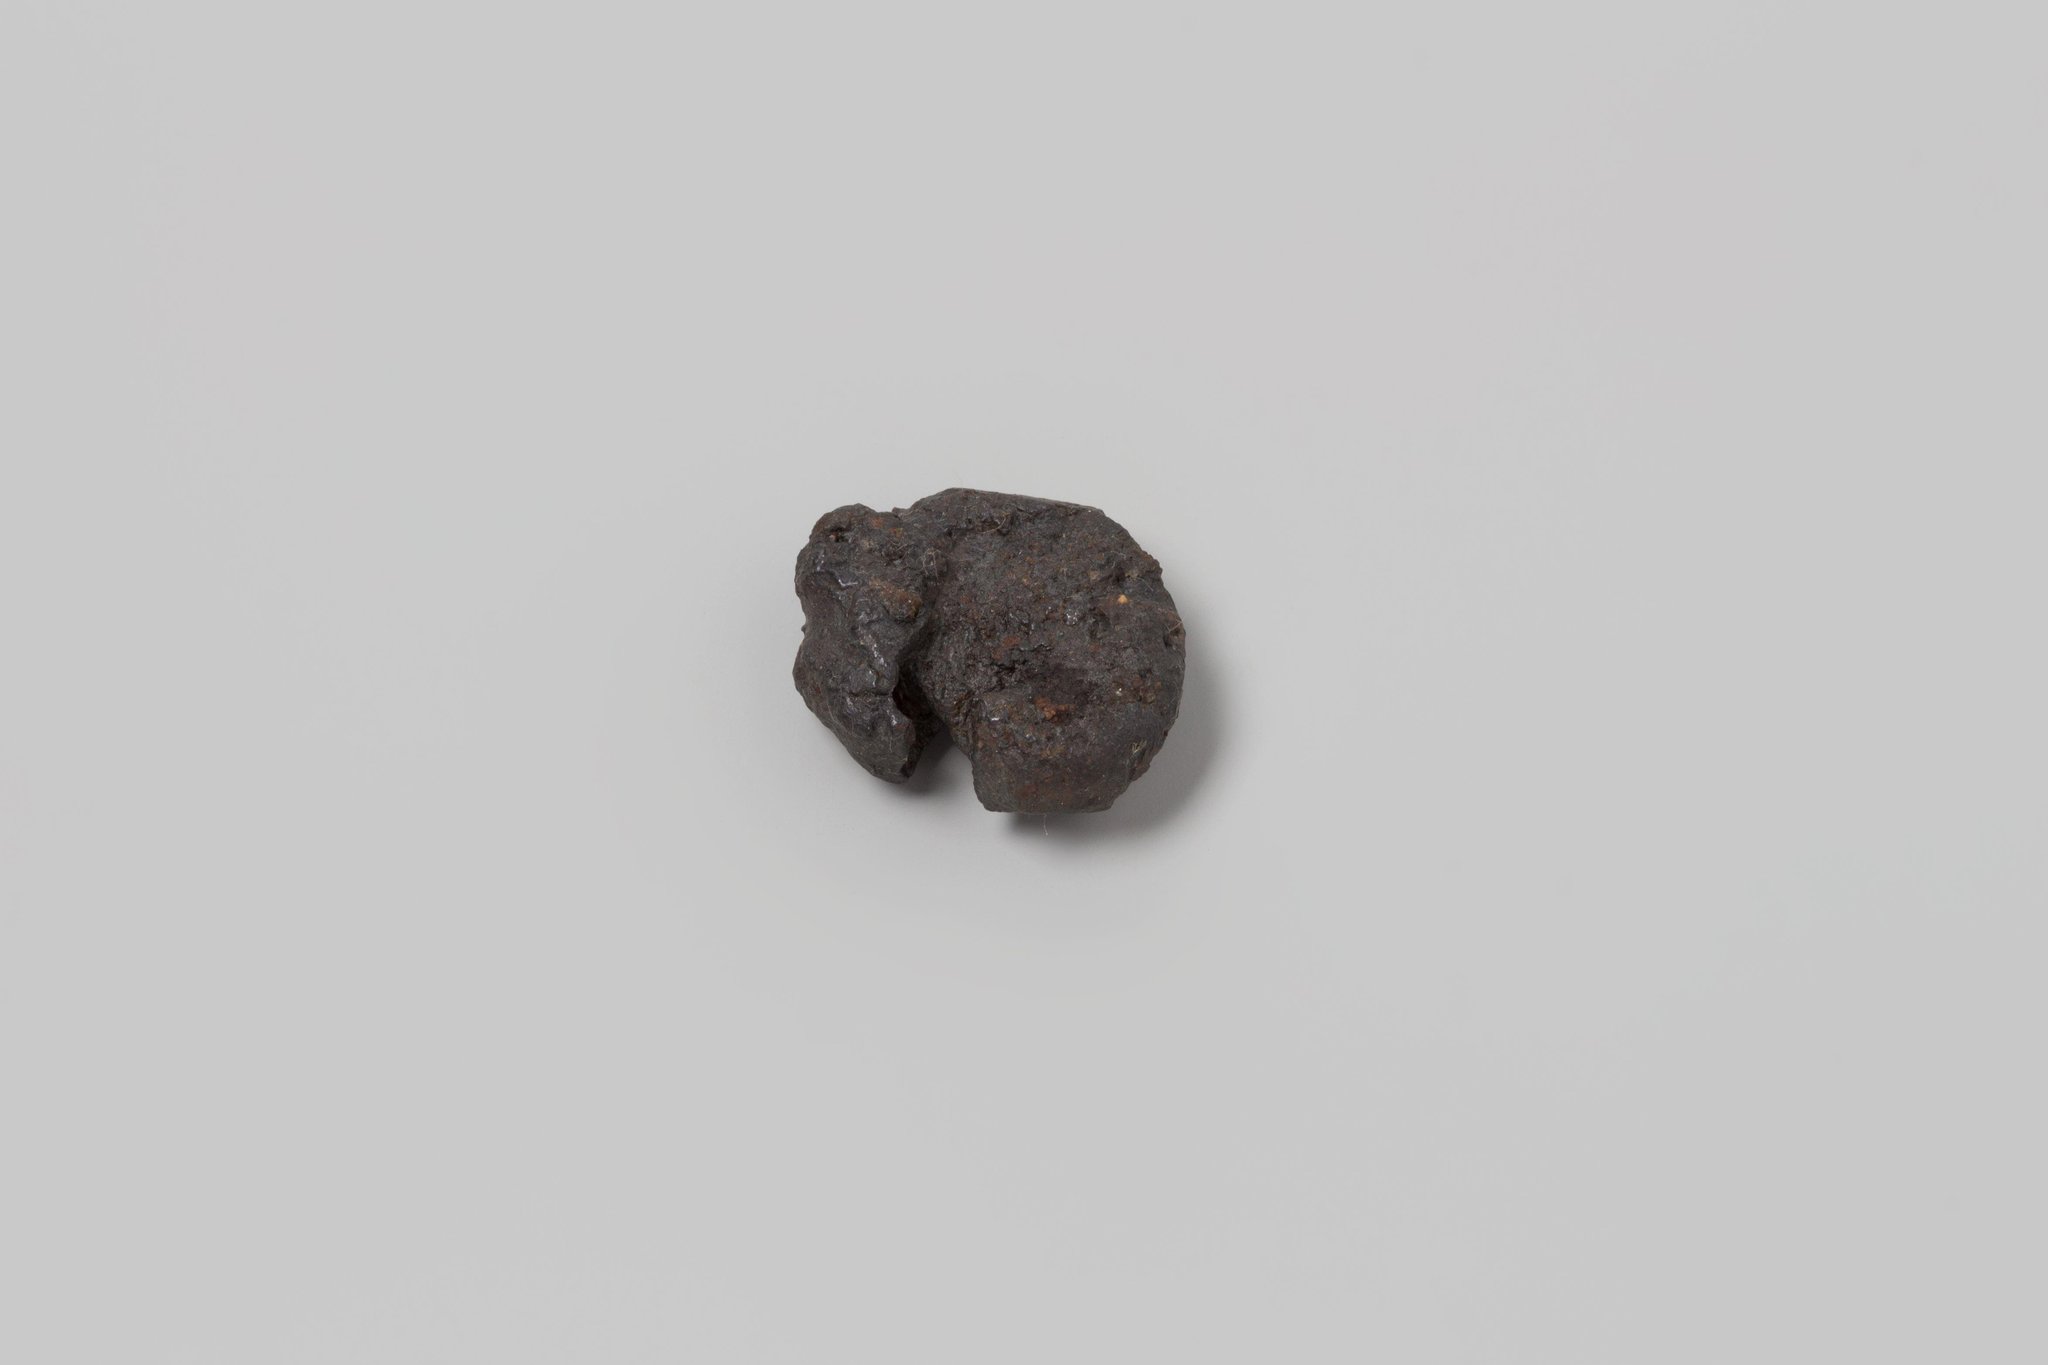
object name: scheepswrakvondst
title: Fragment lood uit het wrak van de Oost-Indiëvaarder Hollandia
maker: Anonymous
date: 1700-1743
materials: lead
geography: netherlands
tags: verenigde oostindische compagnie, hollandia (schip), annet